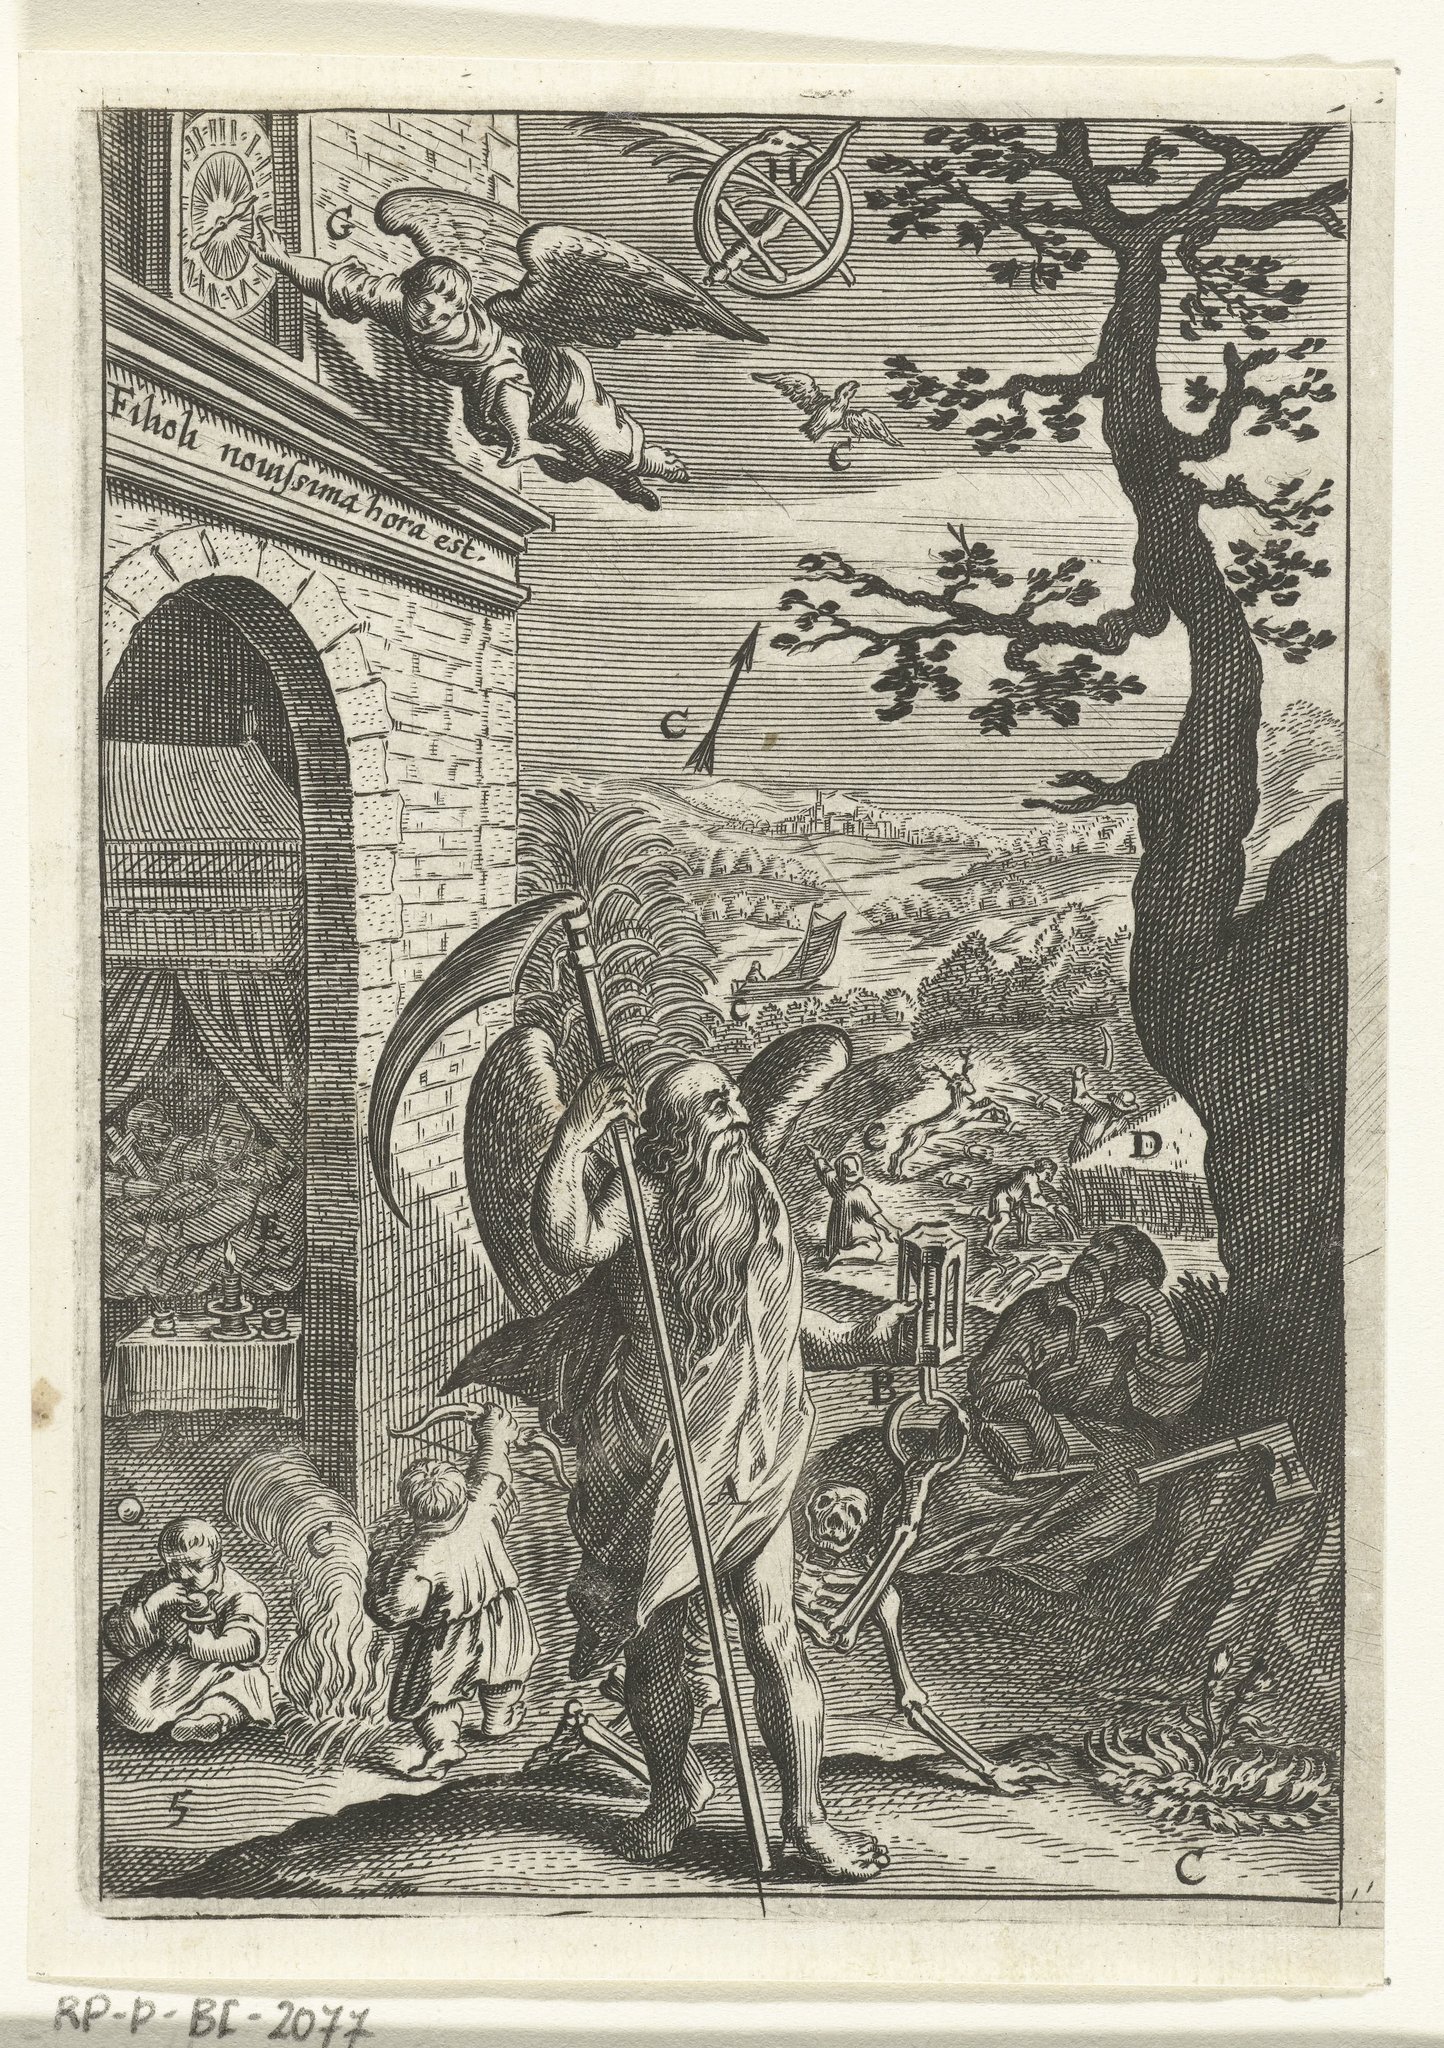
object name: print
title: Embleem met Vader Tijd als symbool voor het voorbijgaan van de tijd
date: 1620-1649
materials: paper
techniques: engraving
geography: antwerp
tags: allegorical representations of the effects of time, father time, man with wings and scythe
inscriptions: collector's mark: Lugt 2228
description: Prent uit: Antoine Sucquet, Den wech des eeuwich levens, beschreven int latijn : met beelden verlicht door Boëtius a Bolsvert, Antwerpen, Hendrick Aertssens, 1620, afb. 5